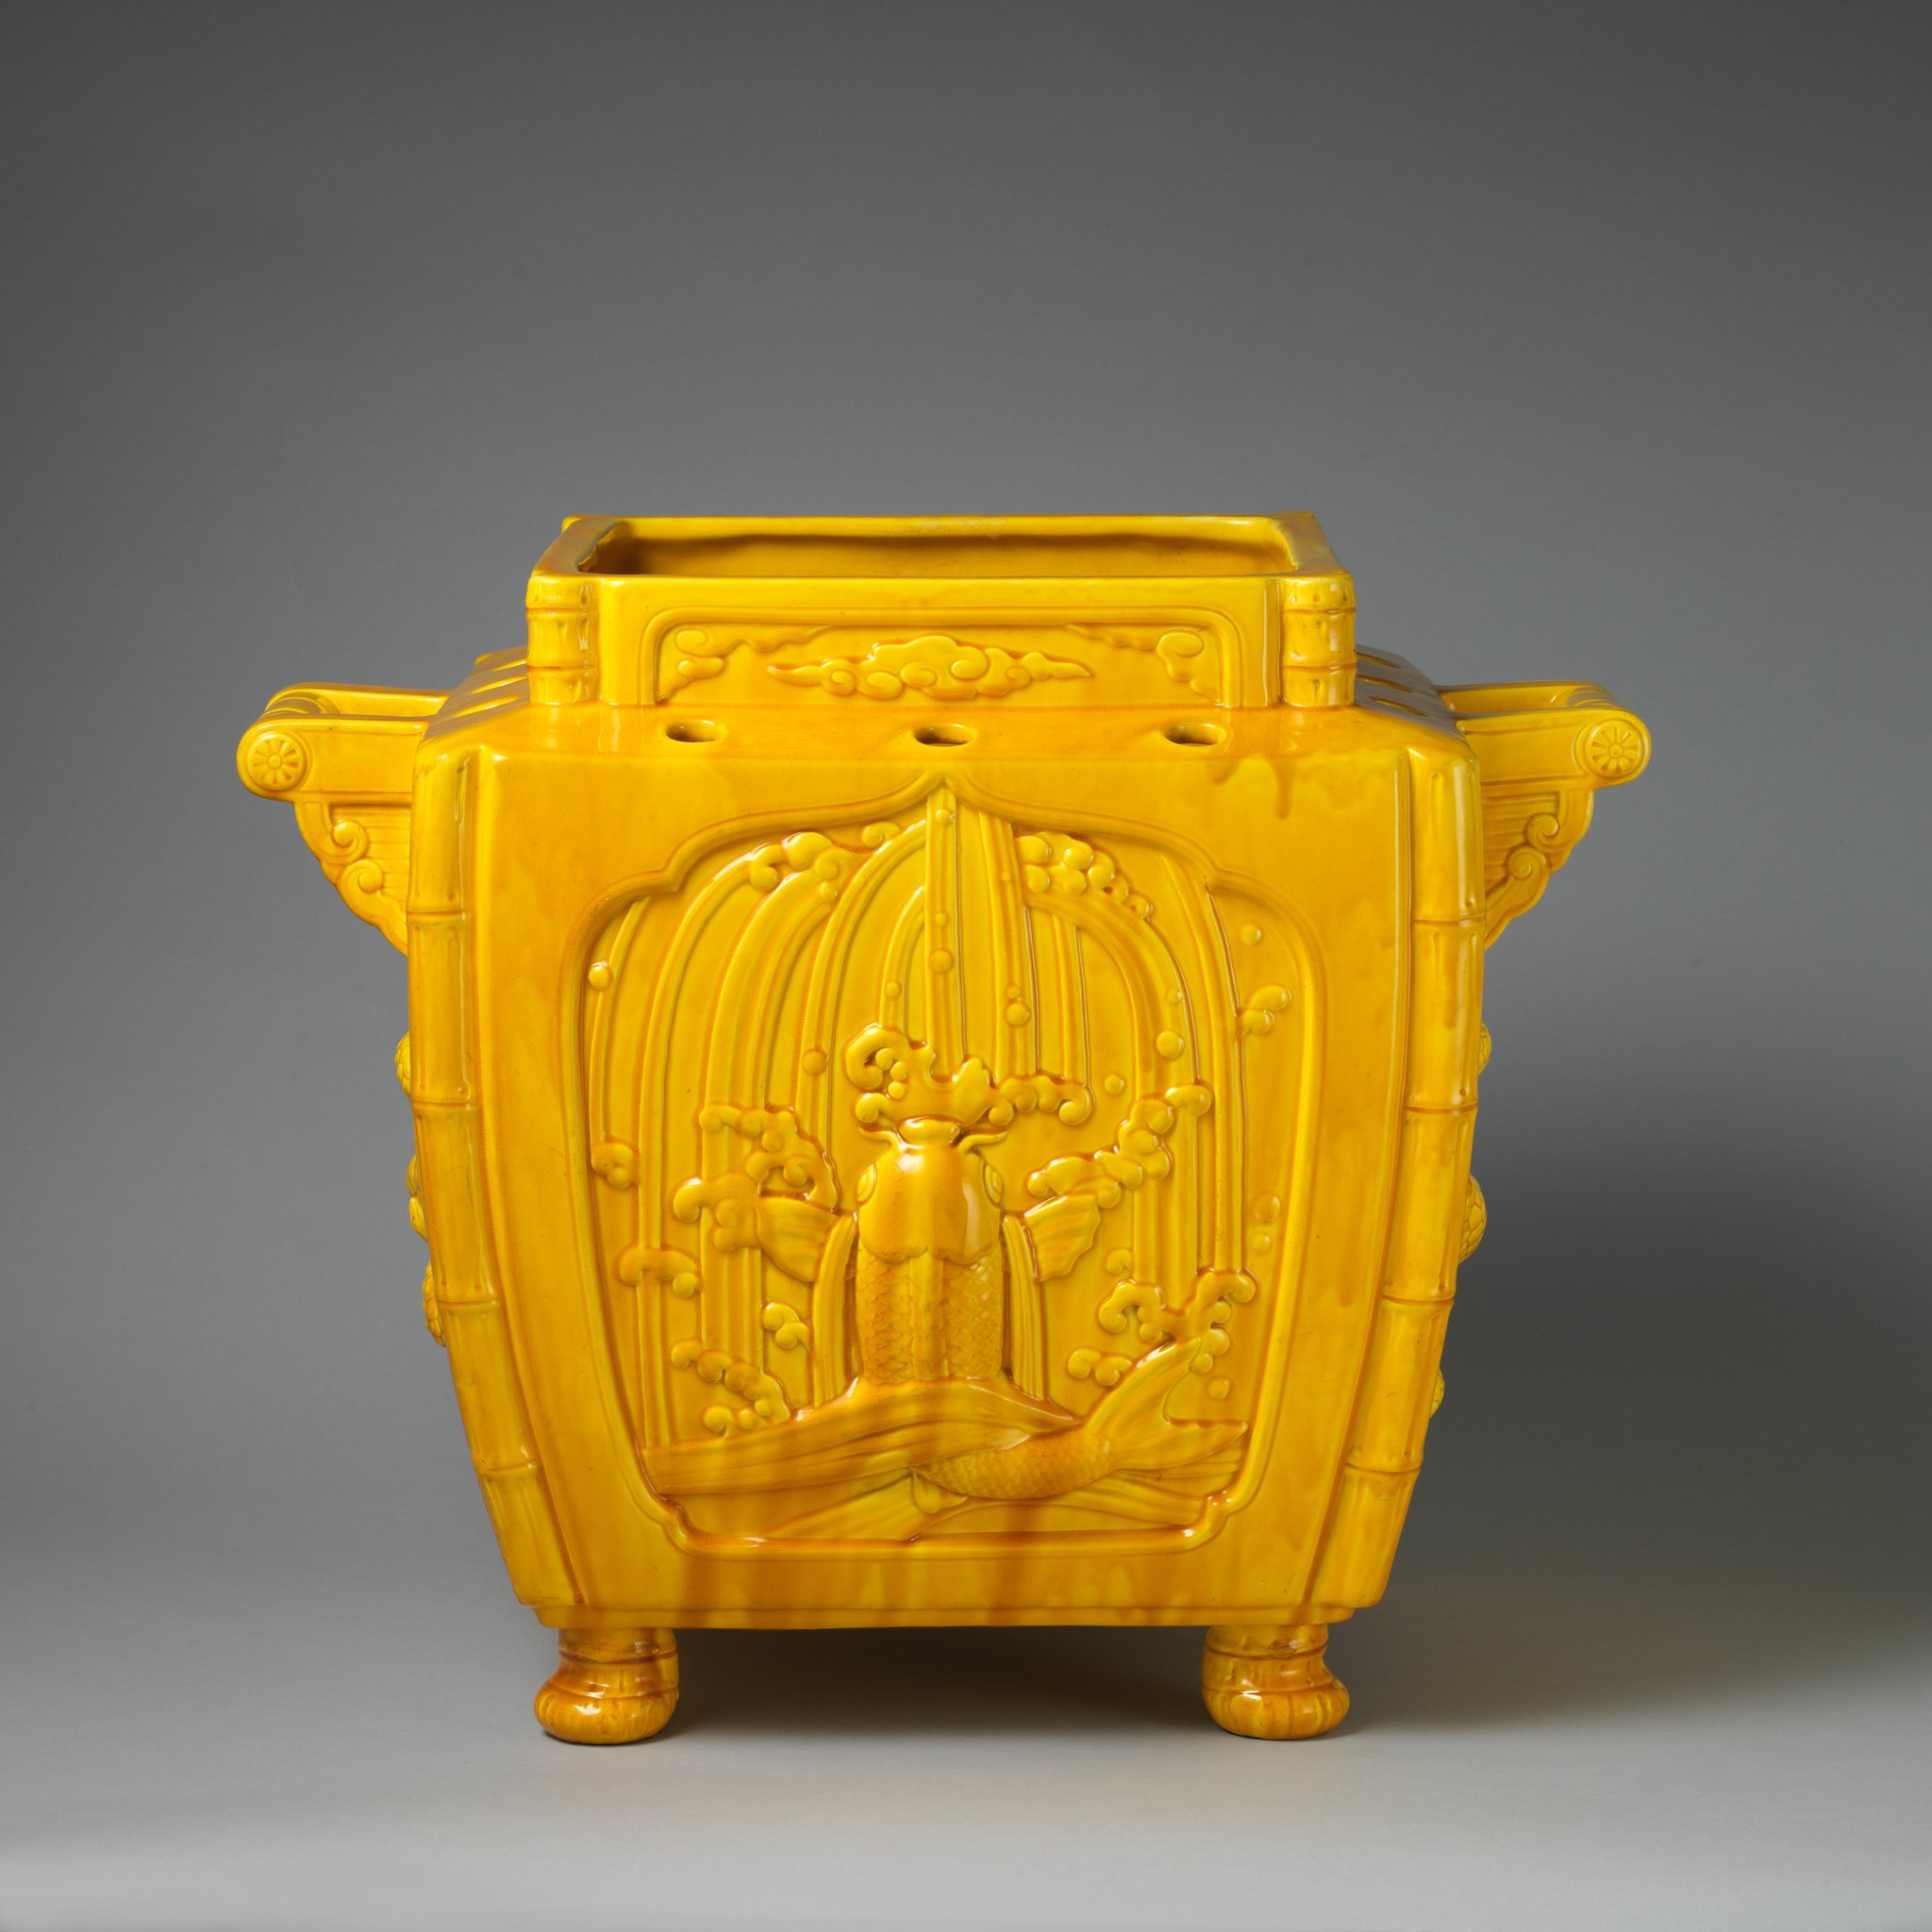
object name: jardinière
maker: christopher dresser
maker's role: modeler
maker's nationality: british, scottish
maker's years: 1834-1904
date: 1883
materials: pottery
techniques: glazing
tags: fish,turtles